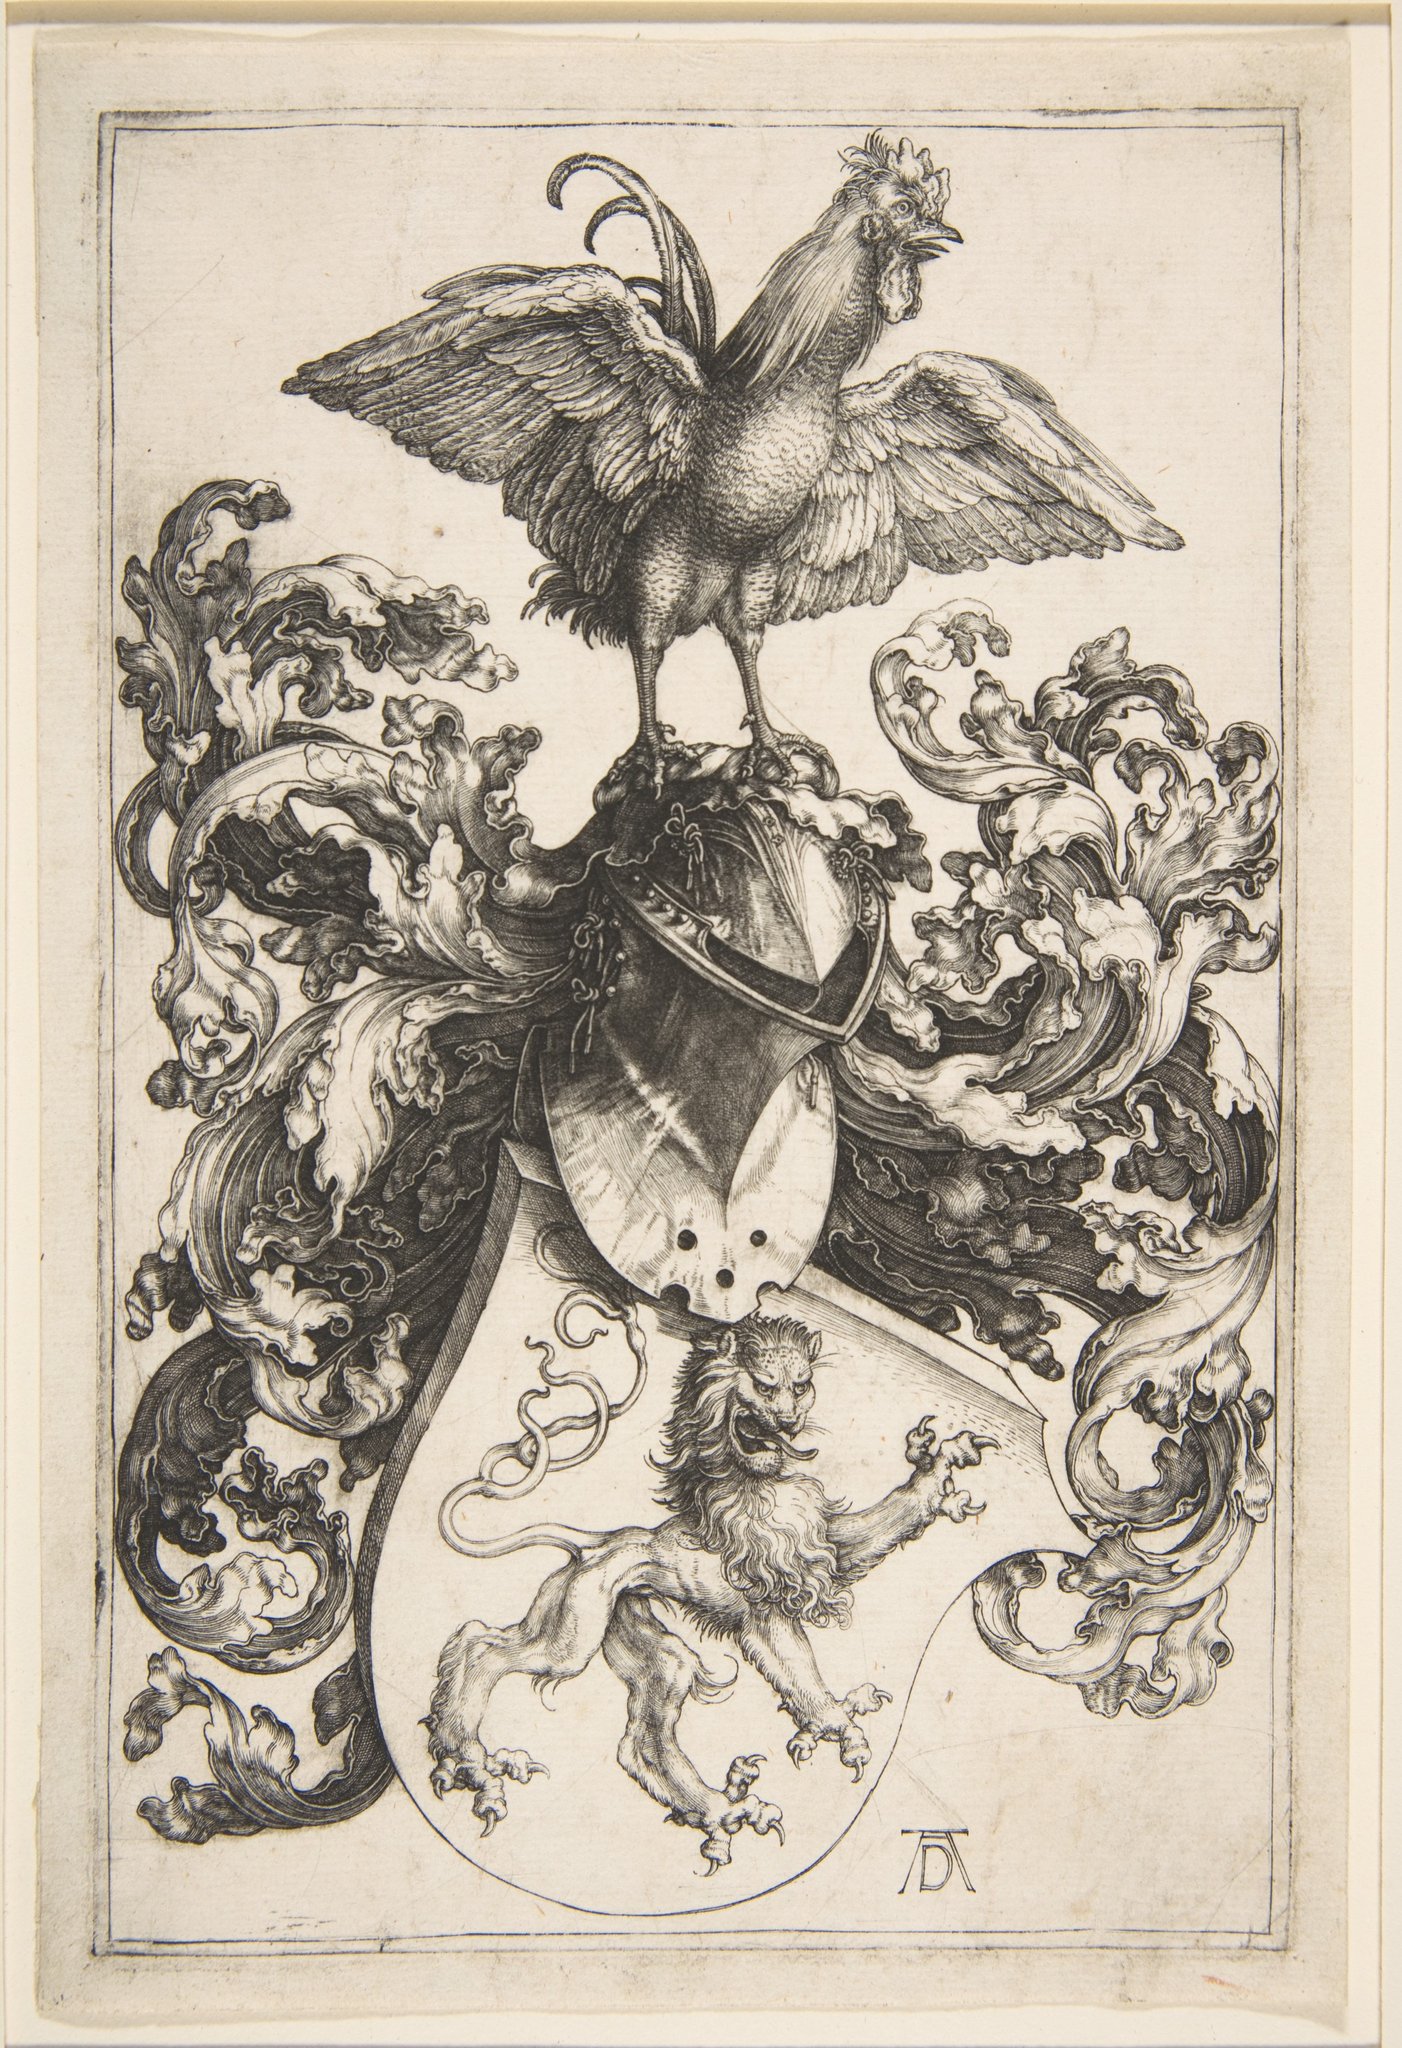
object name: print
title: Coat of Arms with Cock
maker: albrecht dürer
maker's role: artist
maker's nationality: german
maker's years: 1471-1528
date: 1502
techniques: engraving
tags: roosters,lions,leaves,coat of arms